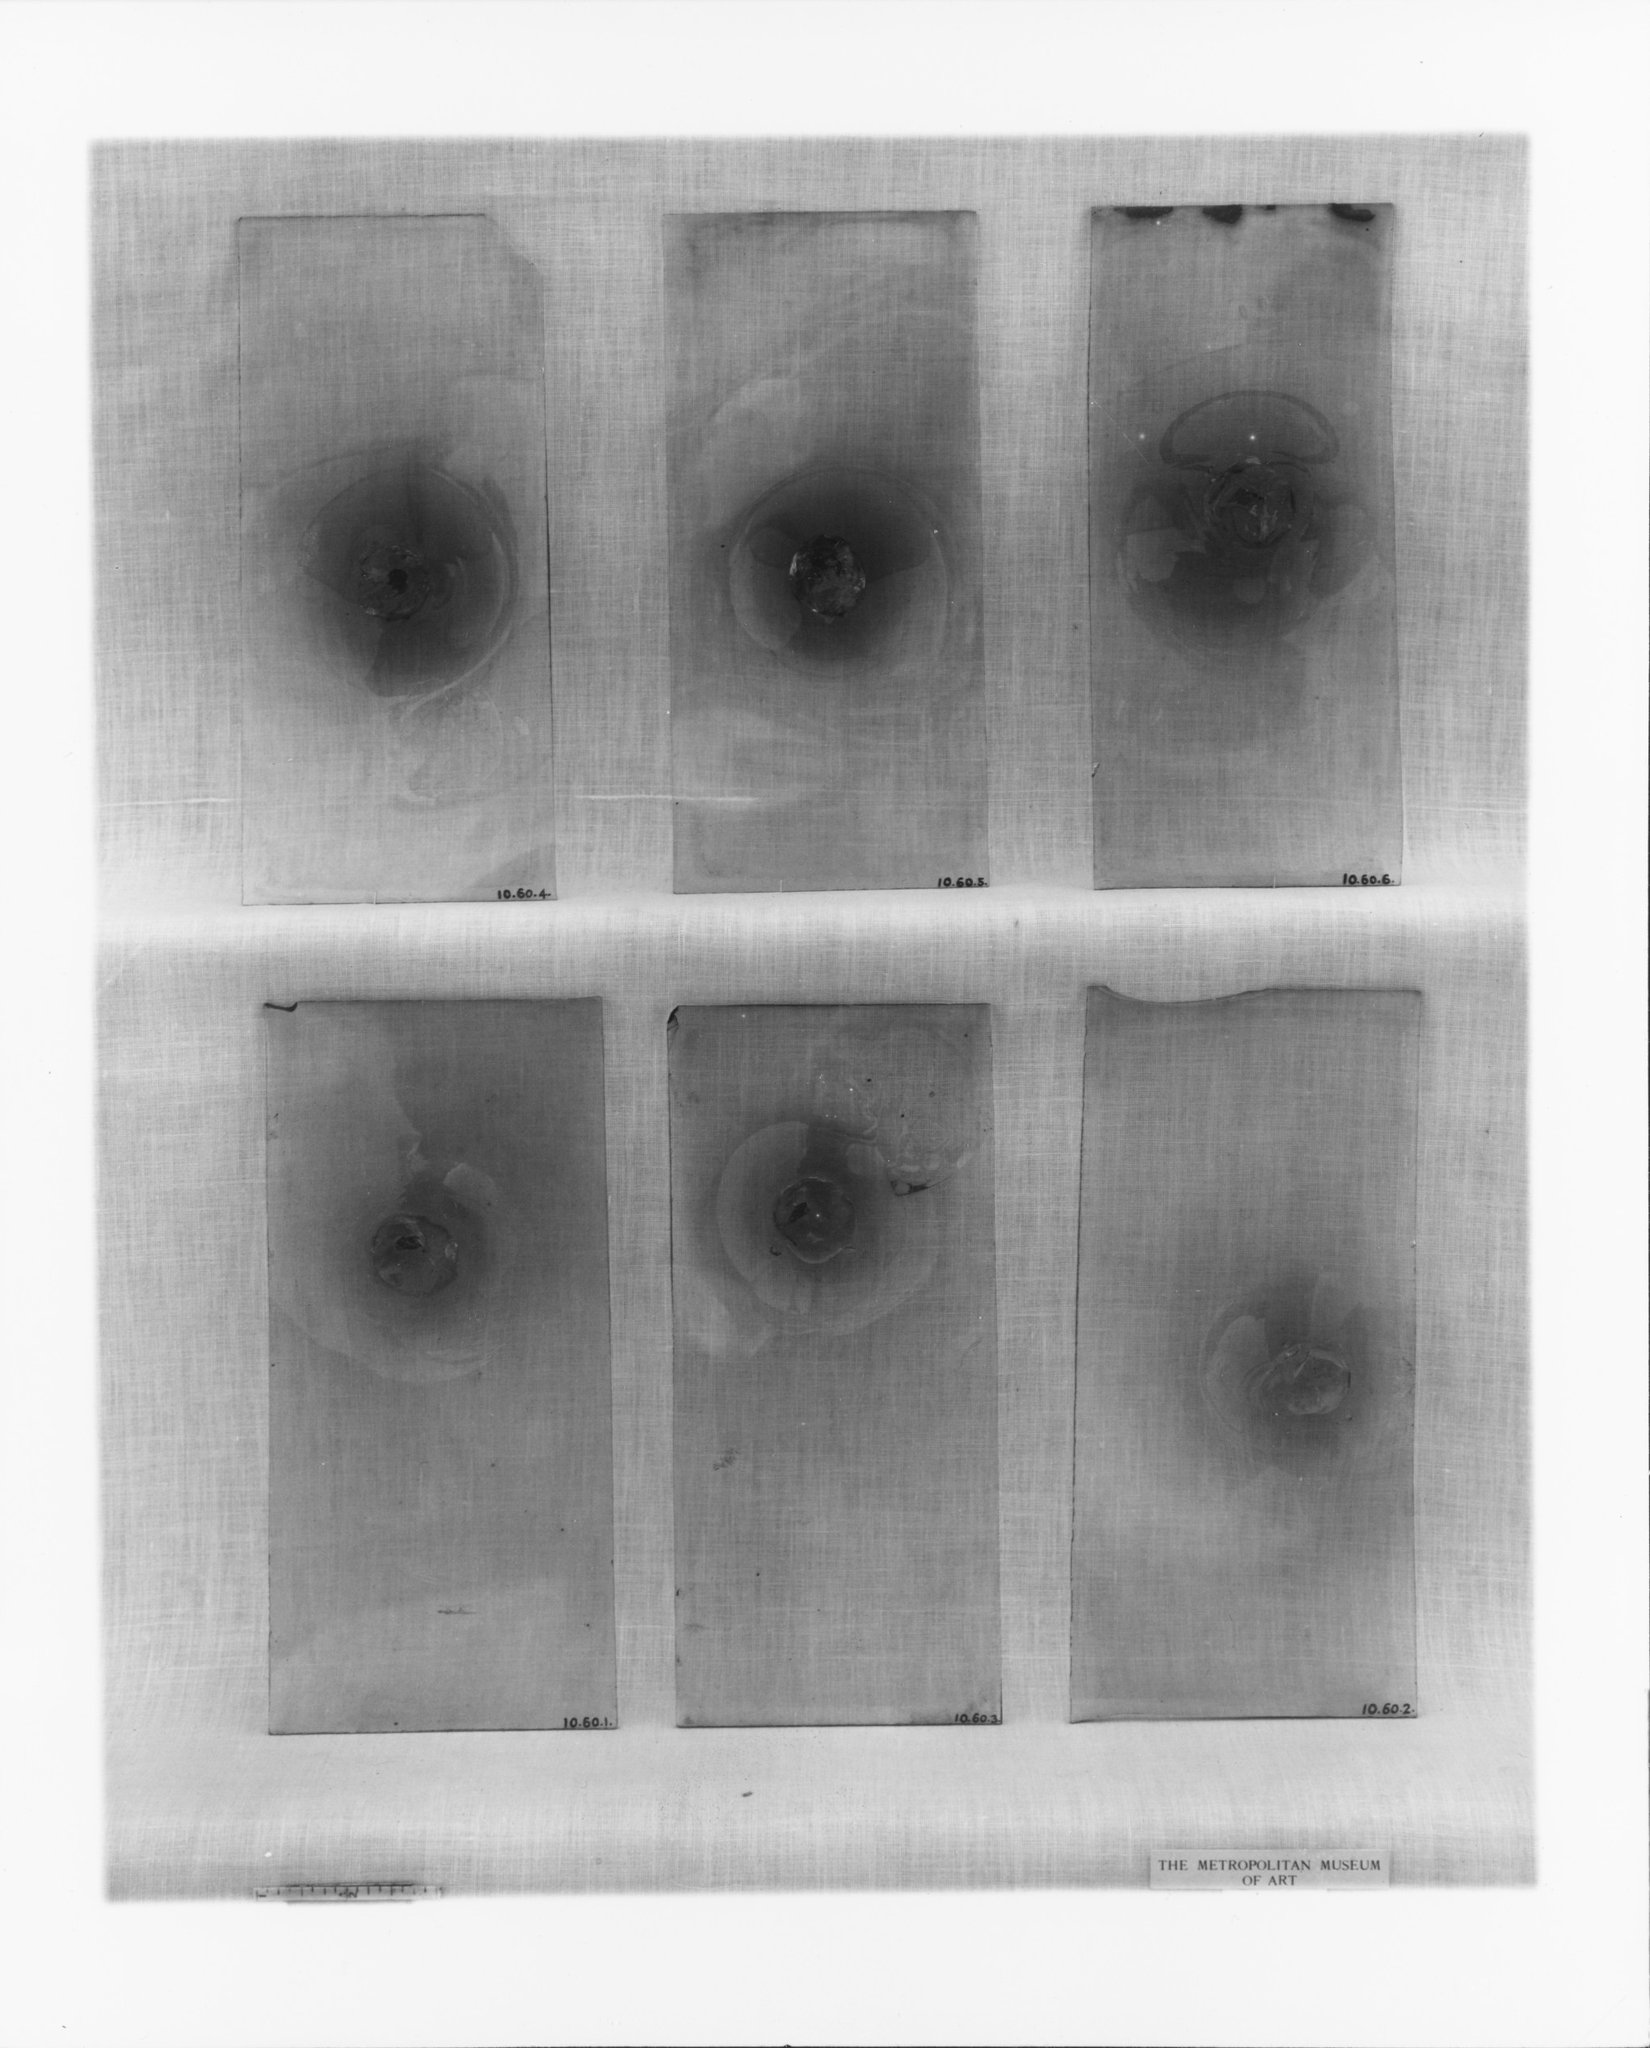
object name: windowpane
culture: american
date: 1701-1800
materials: glass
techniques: glassblowing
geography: united states